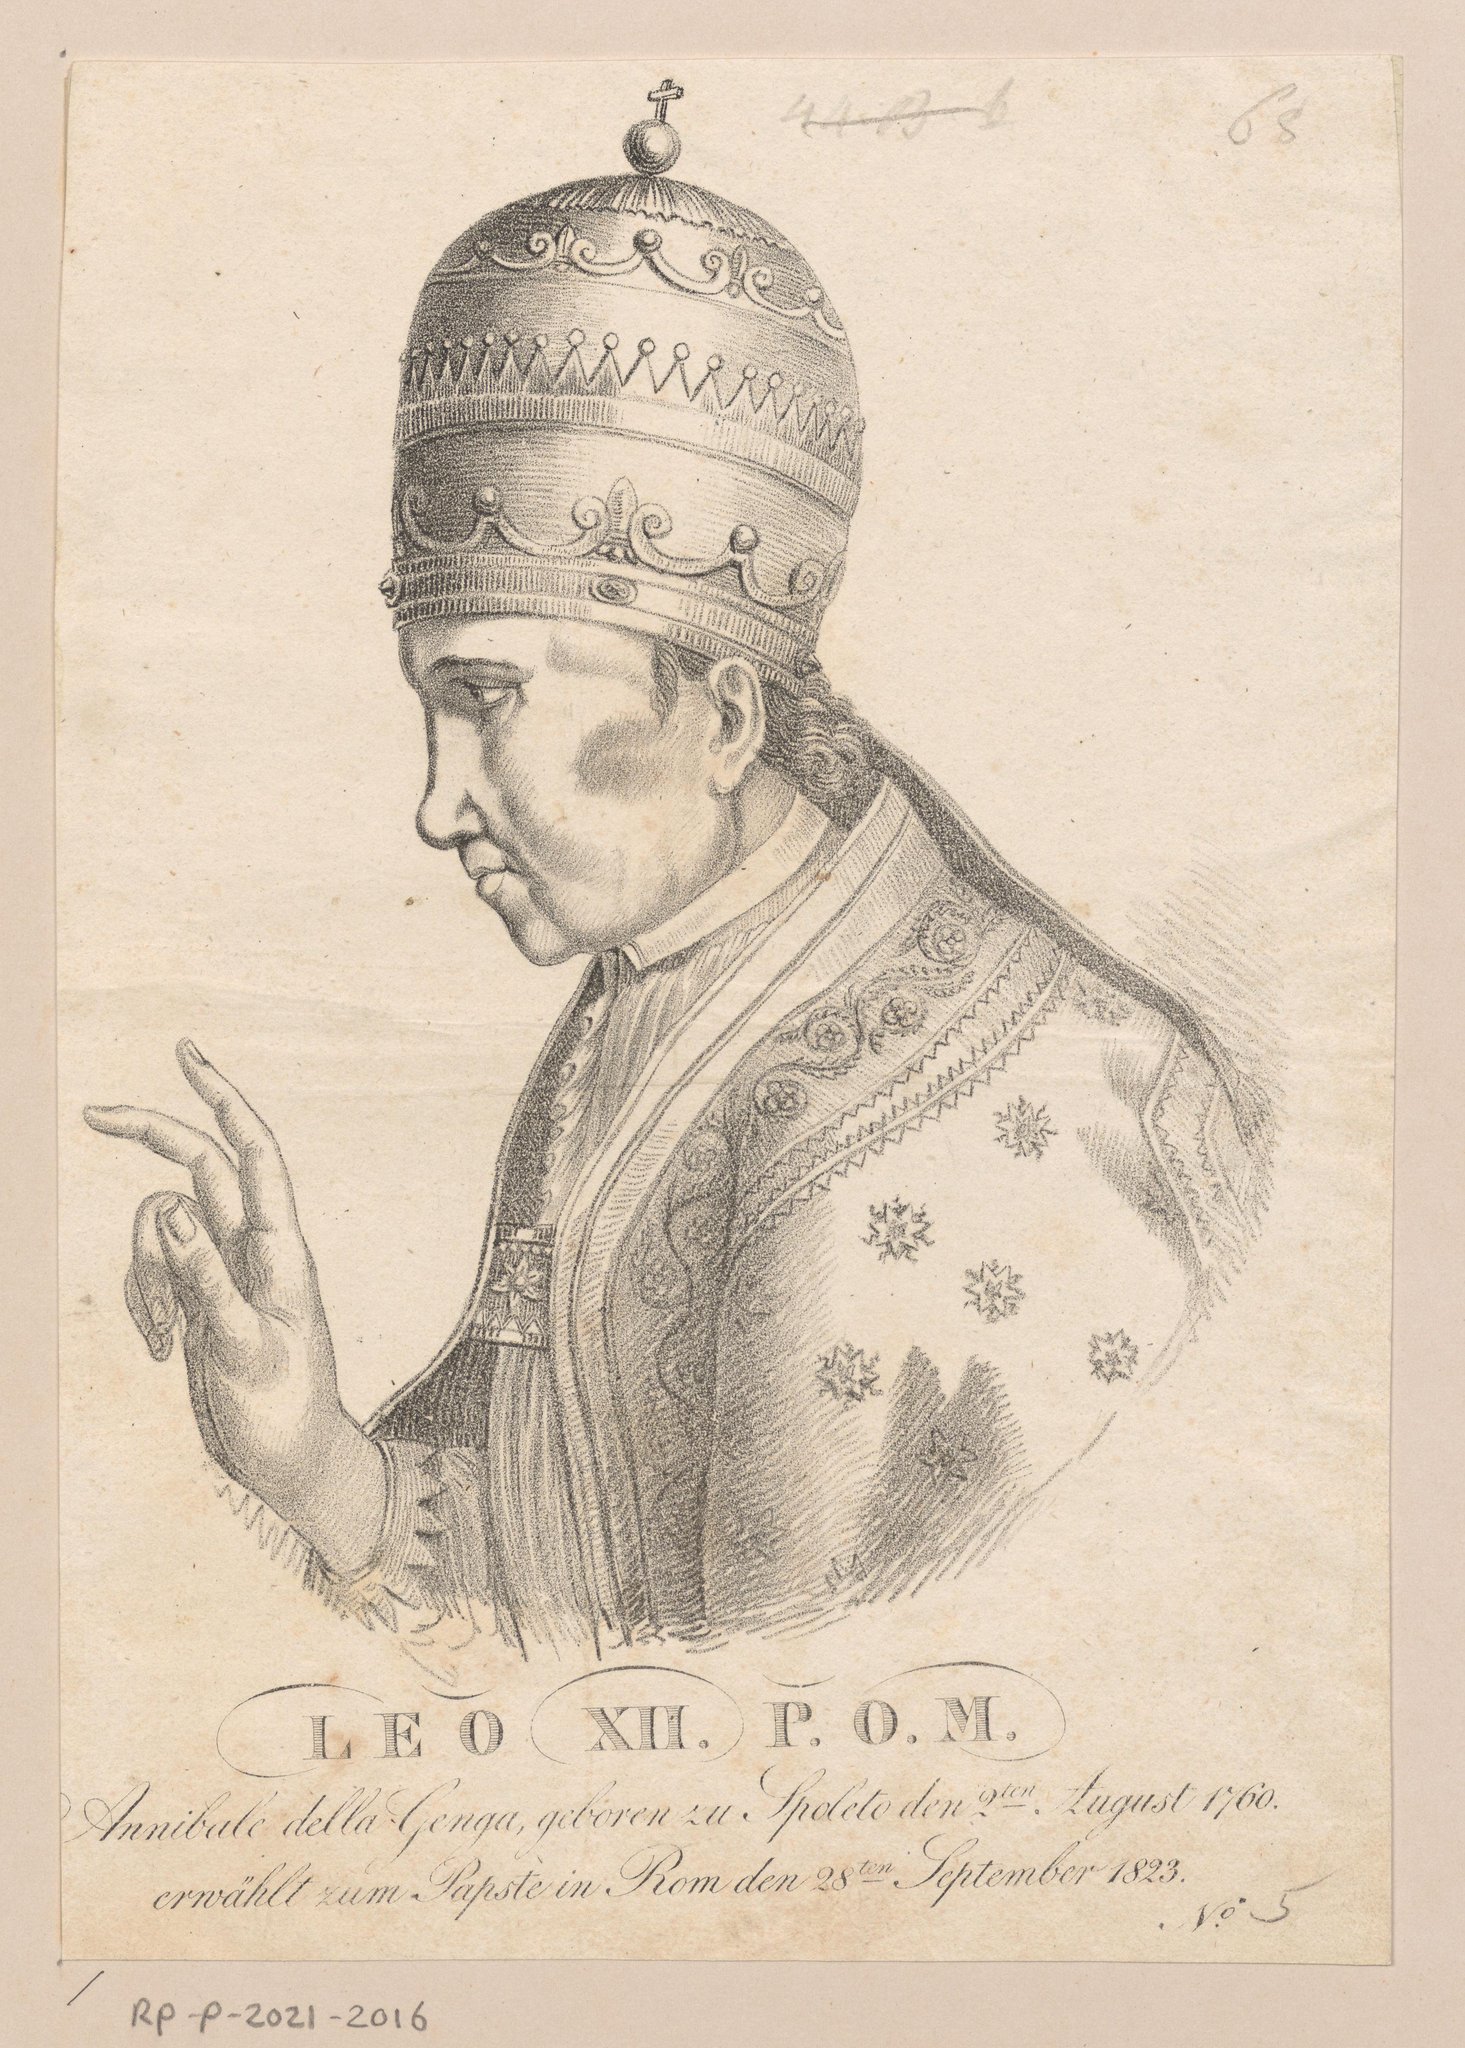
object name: print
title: Portret van paus Leo XII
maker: Anonymous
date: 1823-1899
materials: paper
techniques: lithograph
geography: germany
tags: rome, insignia of the pope, e.g. tiara, historical persons, pope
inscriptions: number: ‘5’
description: Rechtsonder genummerd: No. 5 (5 handgeschreven). Met onderschrift in het Duits.